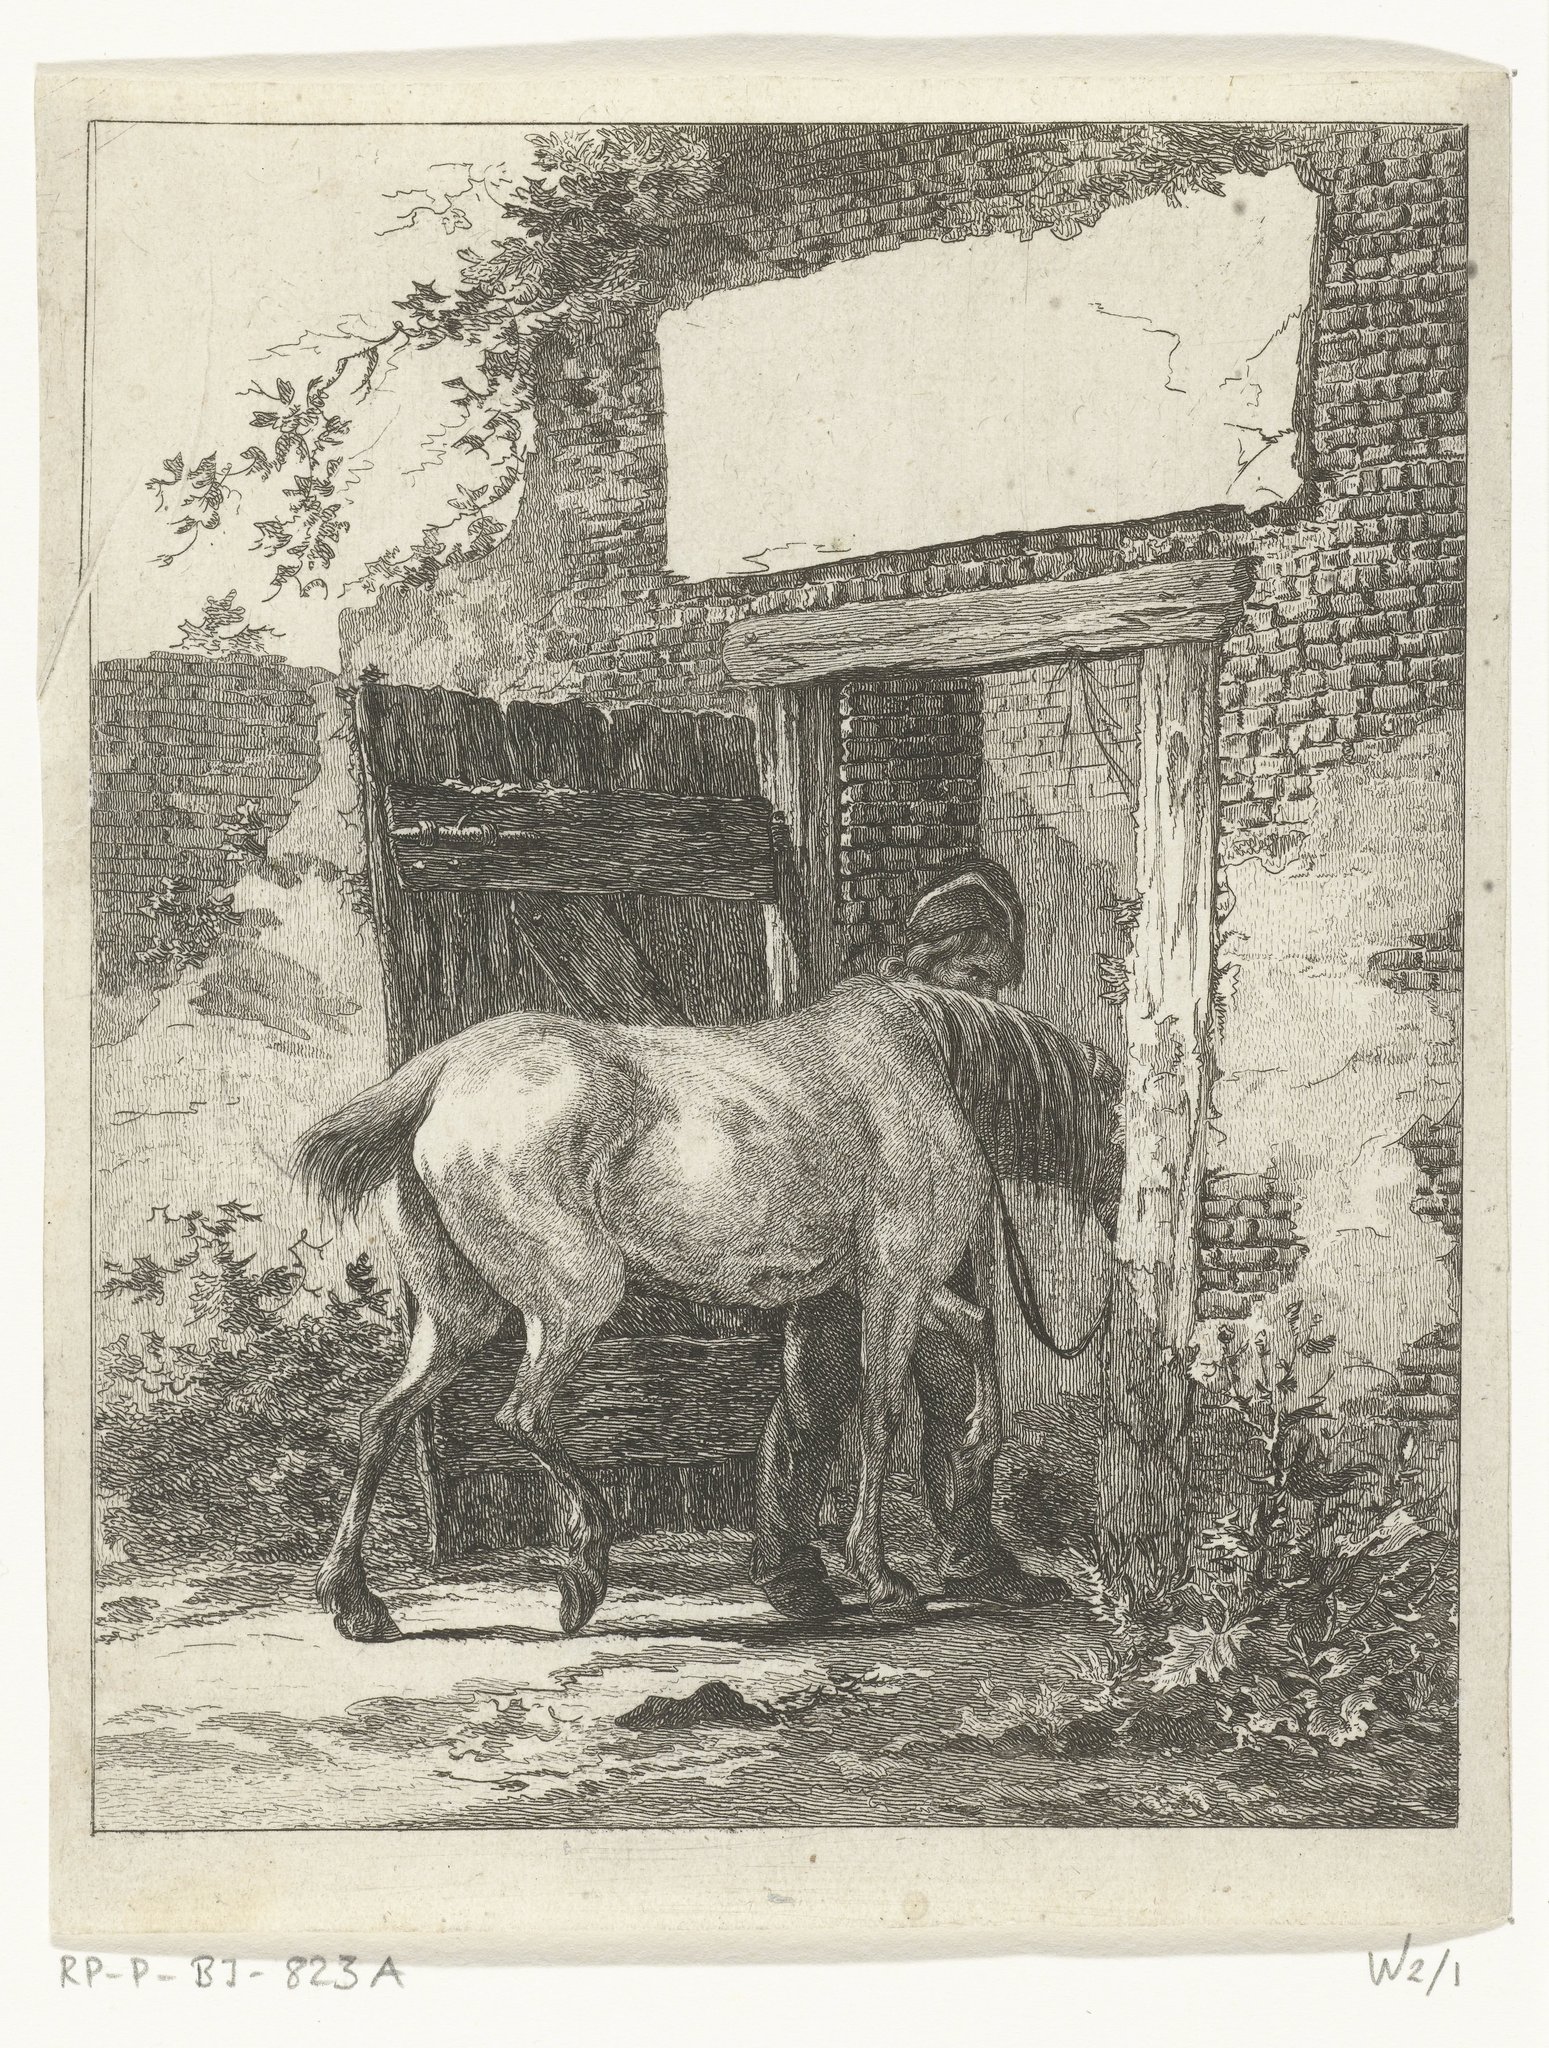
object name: print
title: Paarden met knechten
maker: joannes bemme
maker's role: print maker, printer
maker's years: 1775-1841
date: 1802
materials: paper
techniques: etching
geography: rotterdam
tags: horse, occupations ~ cattle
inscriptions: collector's mark: Lugt 2228